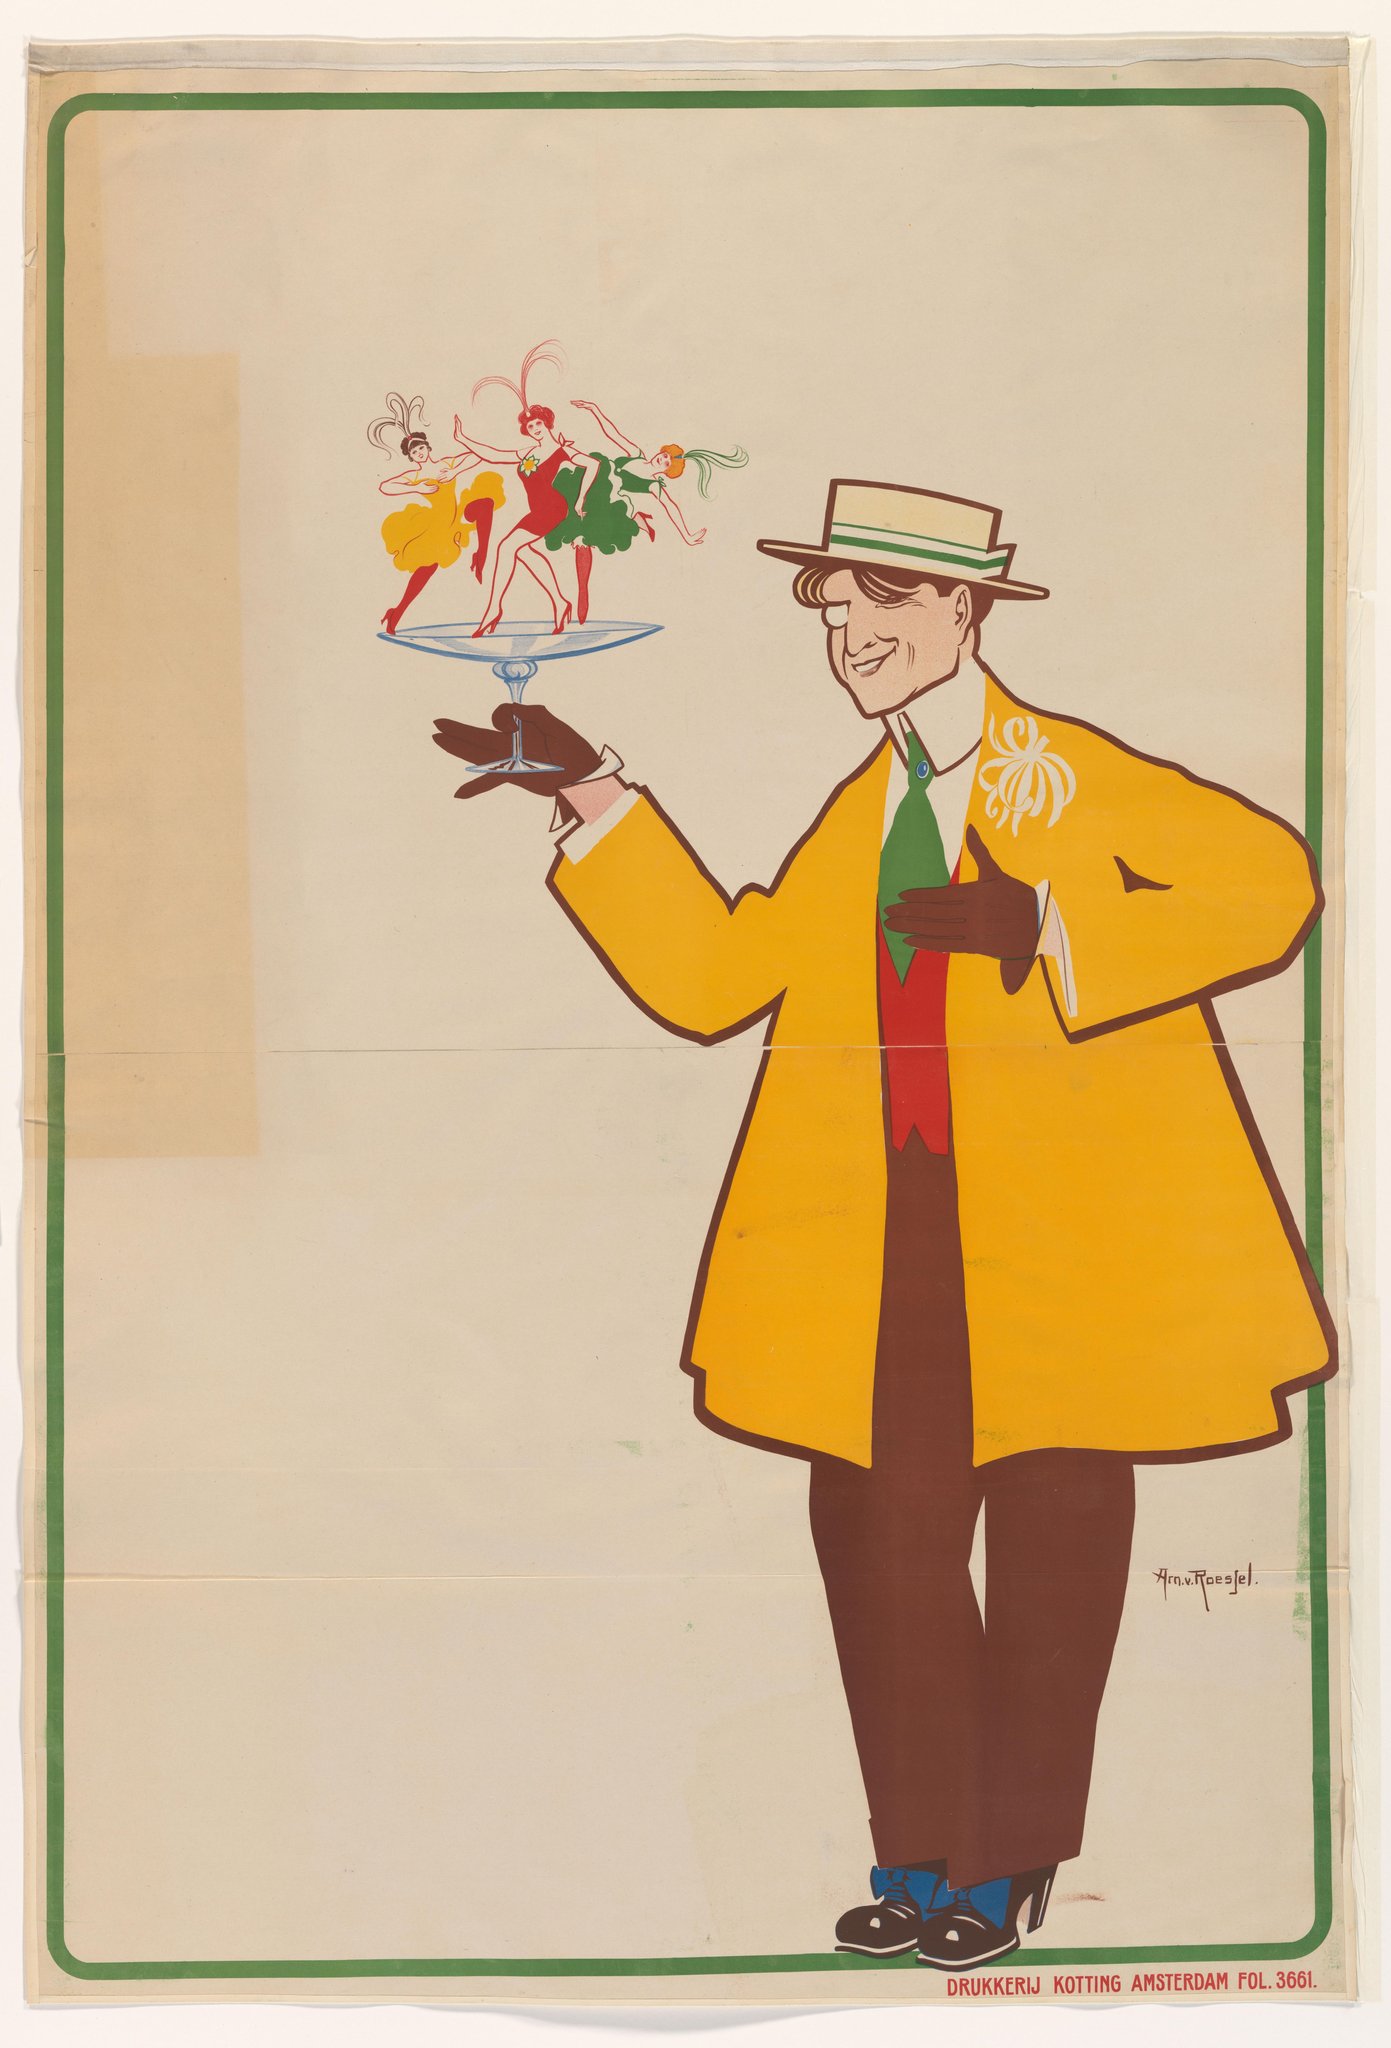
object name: print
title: Affiche voor het Palais de Danse te Scheveningen, 1914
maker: arnold van roessel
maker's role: print maker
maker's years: 1883-1947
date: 1914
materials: paper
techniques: lithograph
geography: amsterdam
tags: man dressed as woman, travesty, ball, formal dance, adult man, female dancer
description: In de collectie van het Haags Gemeentearchief zit een exemplaar met tekst. Waarschijnlijk is dit niet echt een andere staat, maar werd de tekst van een andere steen/drukvorm gedrukt, waardoor dit affiche voor verschillende voorstellingen gebruikt kon worden. Zie RP-P-1914-454 en RP-P-OB-18.216 voor een andere affiche van Roessel, met verschillende tekst.